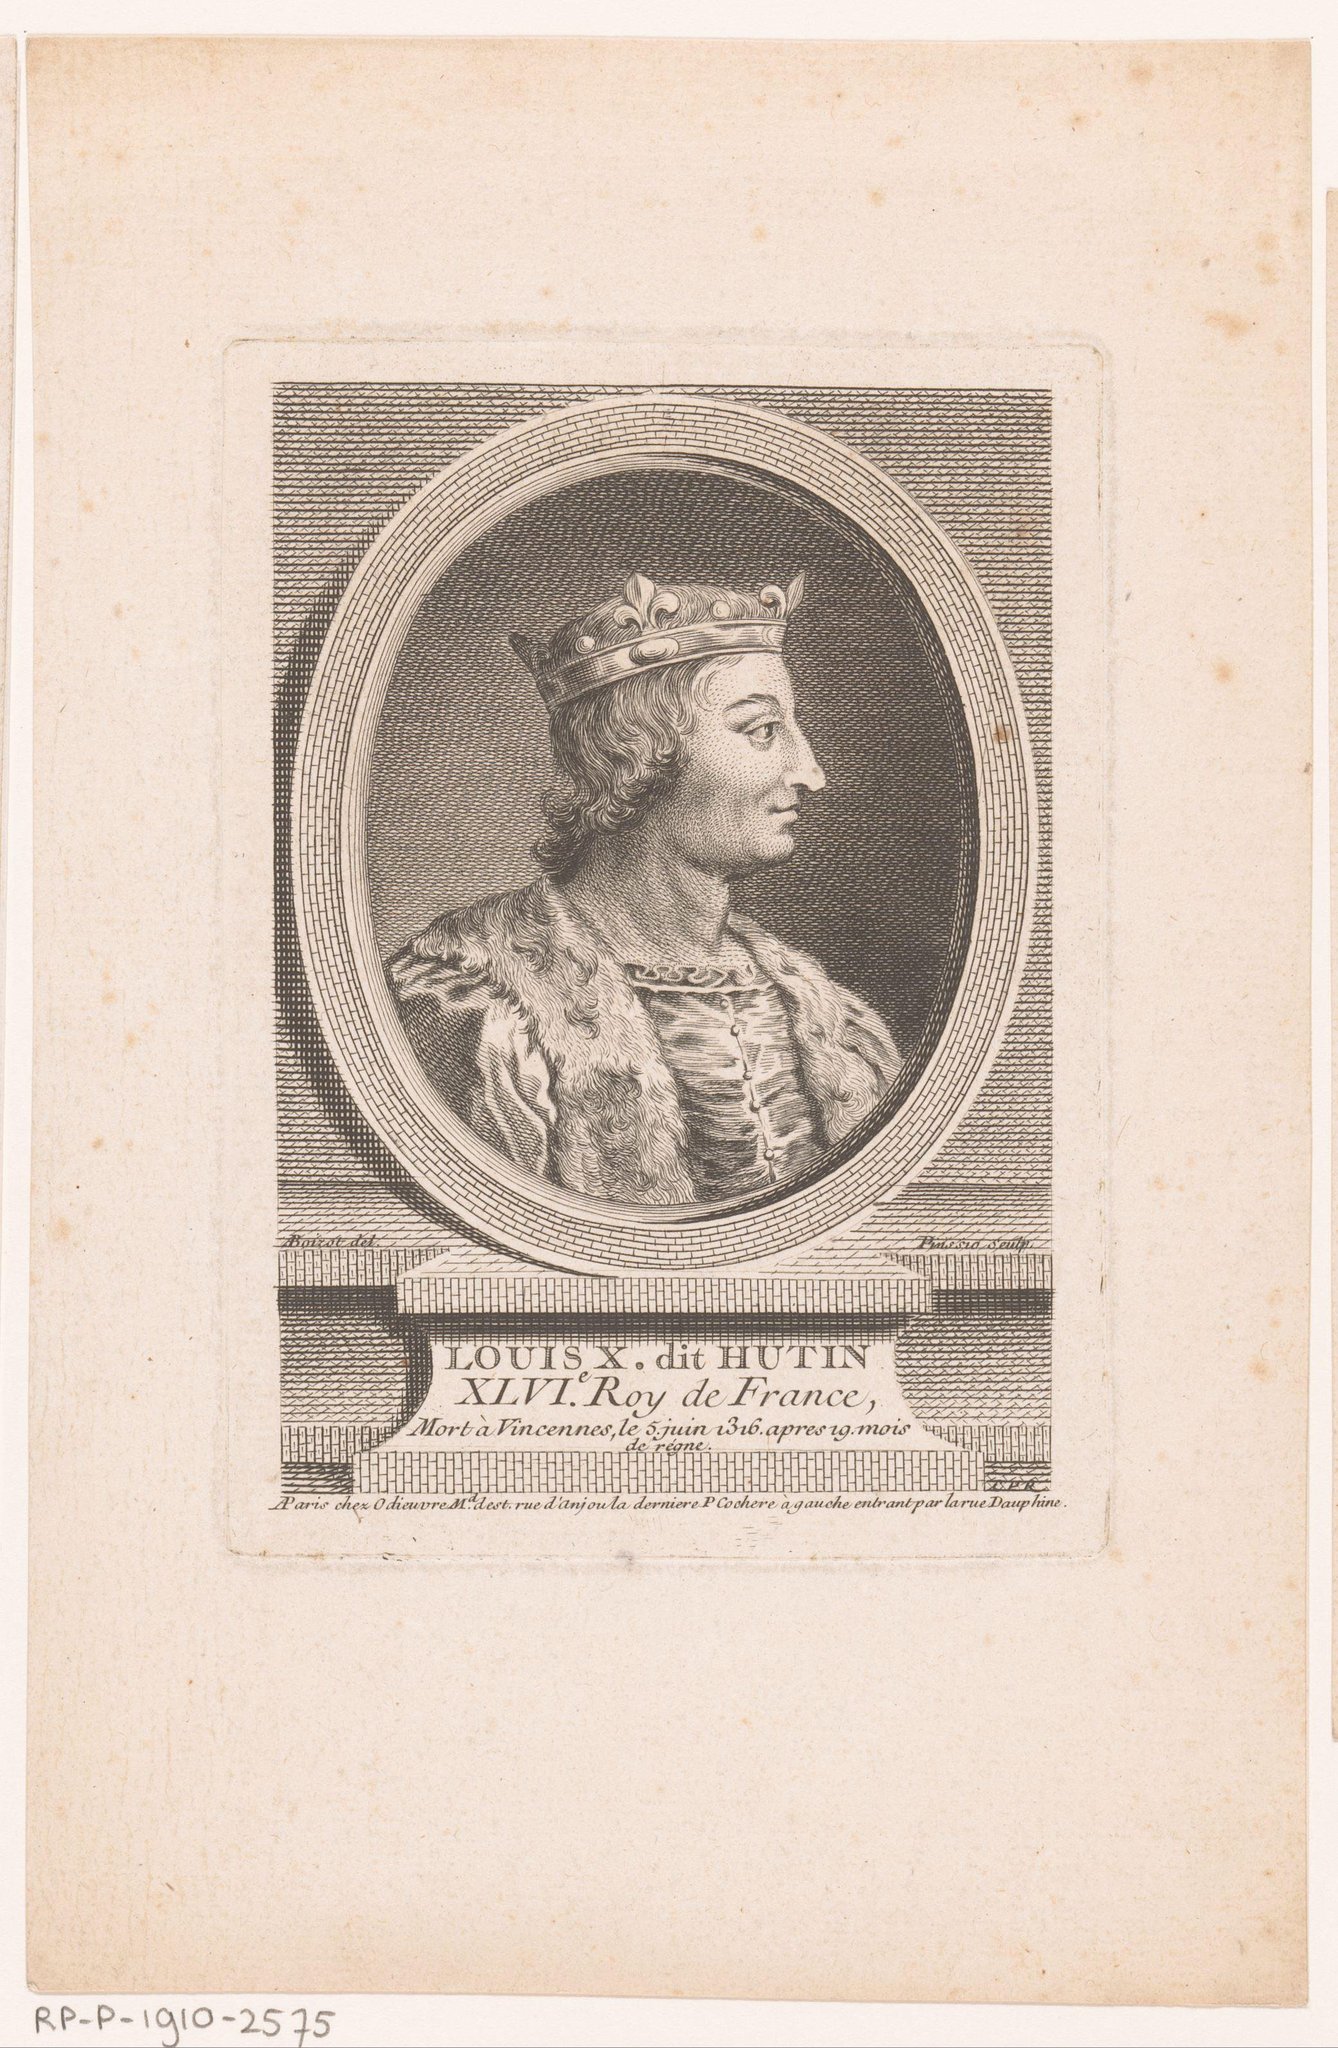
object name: book illustration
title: Portret van Lodewijk X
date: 1755-1765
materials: paper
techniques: engraving, etching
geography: france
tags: paris, historical persons, king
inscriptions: collector's mark: Lugt 2228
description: Prent uit: Dreux du Radier, Jean-François. L'Europe illustré, contenant l'histoire abregée des souverains, des princes, des prélats, des ministres, (...) en Europe: dans le XVe. siècle compris, jusqu'à présent. Parijs: Michel Odieuvre en André-François Le Breton, 1755-1765.